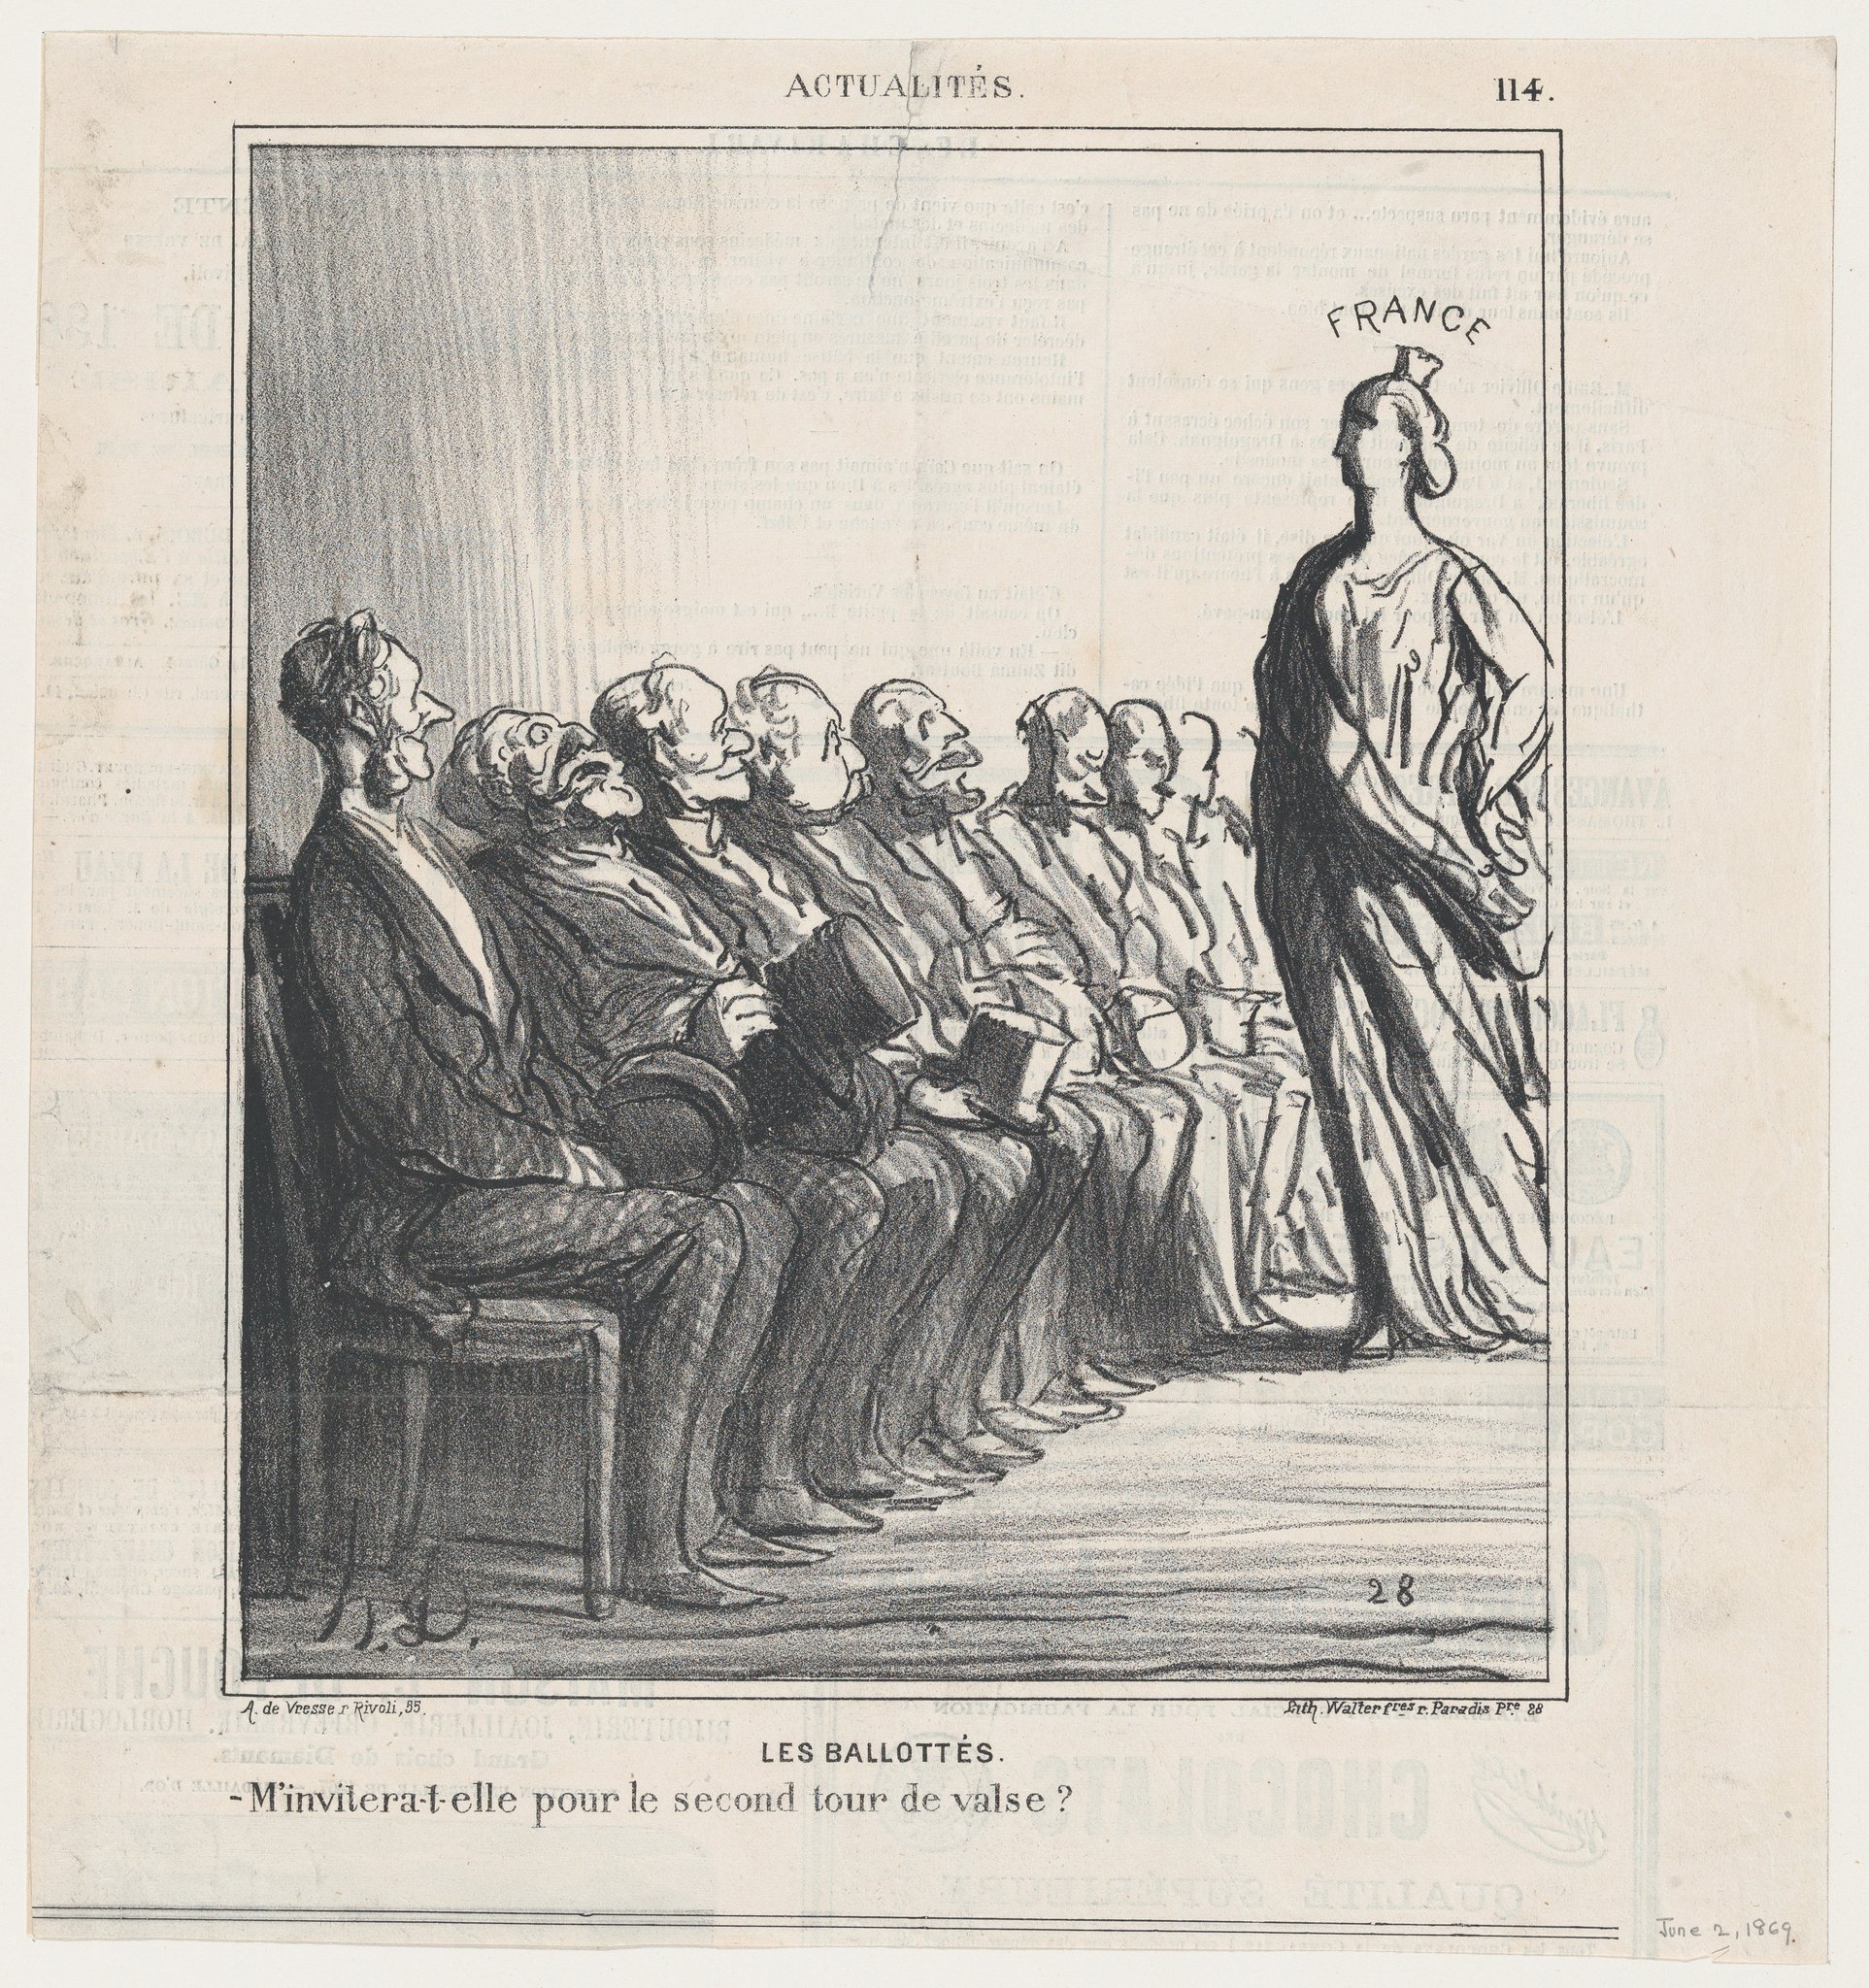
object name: print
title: Run-off elections: Will she invite me for a second waltz?, from 'News of the day,' published in Le Charivari, June 2, 1869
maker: honoré daumier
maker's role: artist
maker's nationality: french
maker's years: 1808-1879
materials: paper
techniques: lithograph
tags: satire,men,women